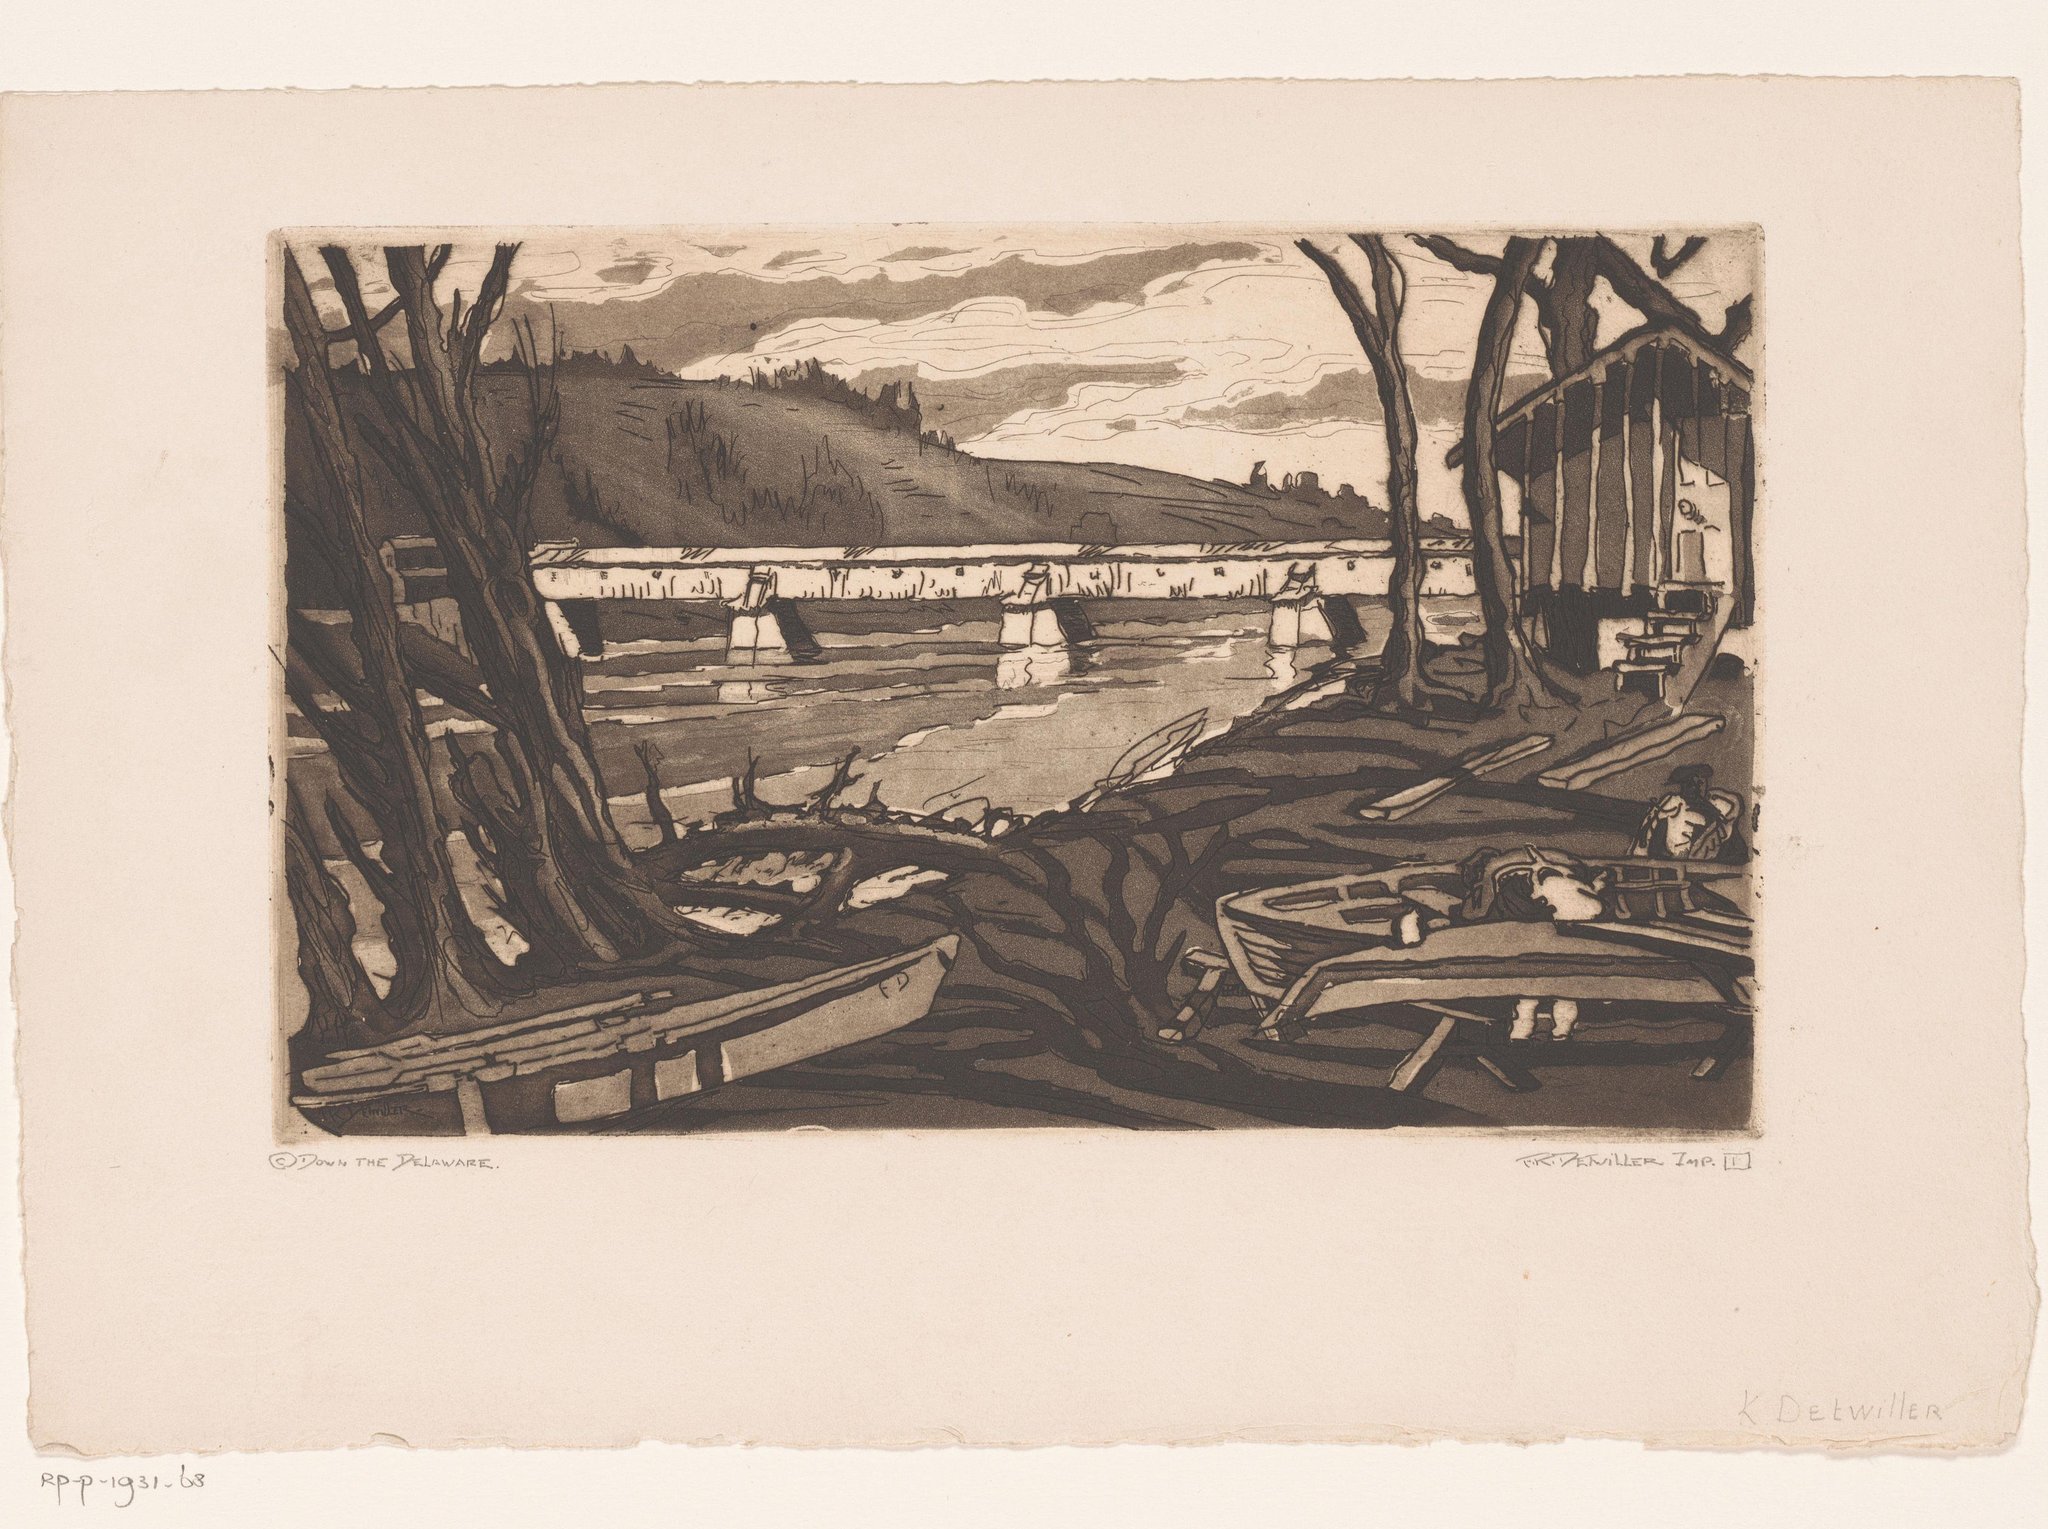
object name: print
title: Down the Delaware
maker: frederick knecht detwiller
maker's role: print maker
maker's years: 1882-1953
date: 1892-1931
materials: paper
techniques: aquatint, etching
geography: new york city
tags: bridge in village across river, canal, etc.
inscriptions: collector's mark: Lugt 2228